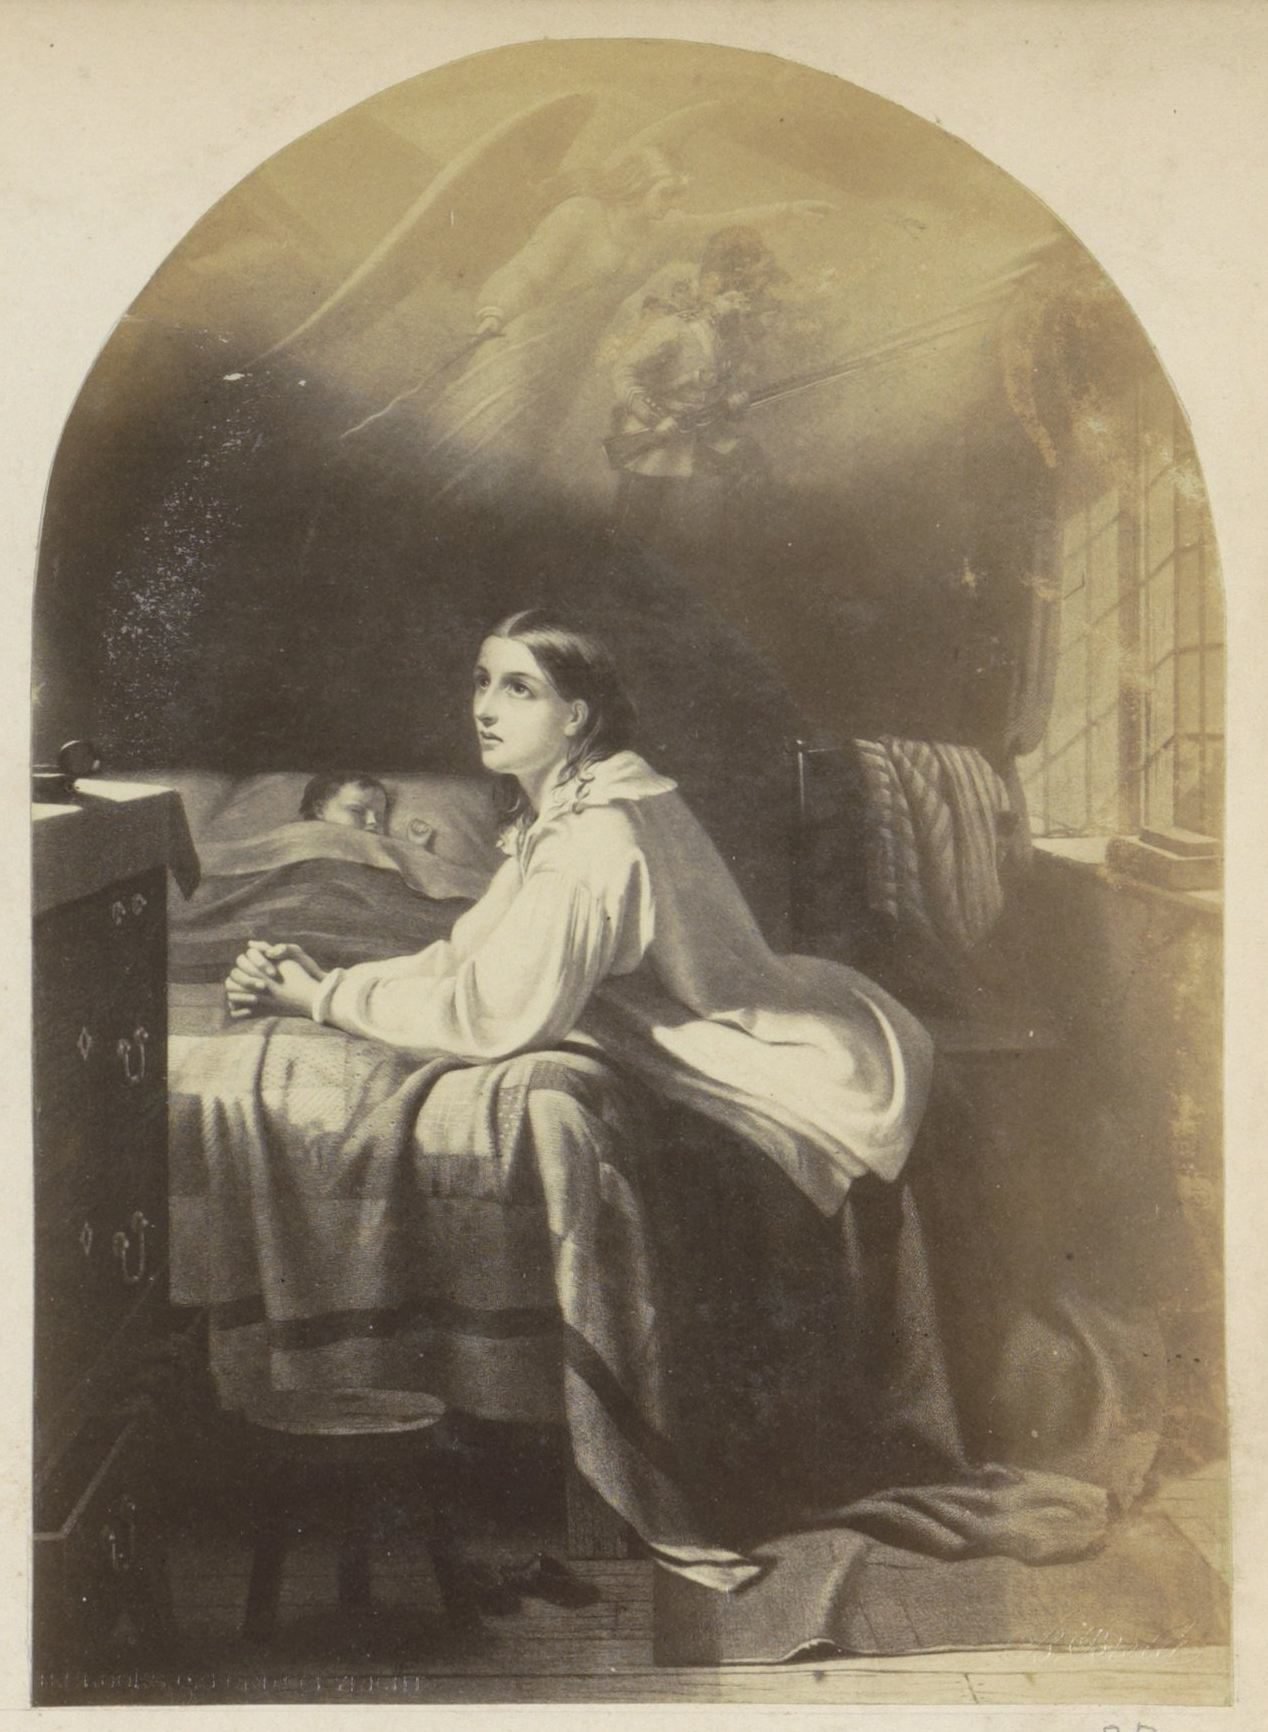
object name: photograph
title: Fotoreproductie van (vermoedelijk) een schilderij van een moeder biddend bij een kind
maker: Anonymous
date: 1850-1870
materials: paper, photographic support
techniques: albumen print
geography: england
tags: mother and baby or young child, one person praying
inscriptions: check stamp: ‘[...]’, check stamp: ‘B. Brooks Oxford Copyright’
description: Onderdeel van Album met foto's van bezienswaardigheden en landschappen in Engeland en van kunst.